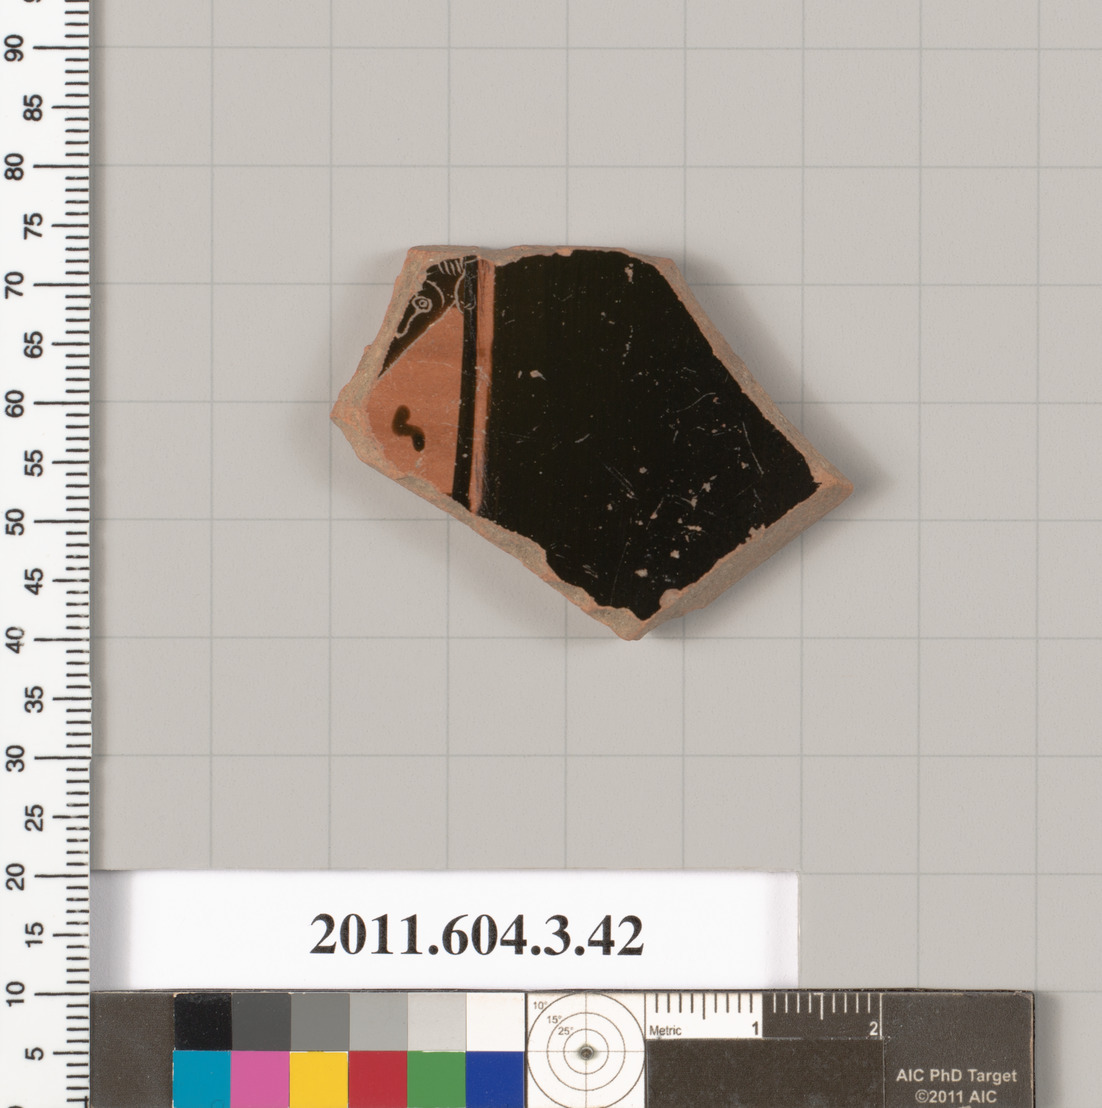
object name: amphora fragment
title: Terracotta fragment of an amphora (jar)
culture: greek, attic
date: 530-520 BCE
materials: terracotta